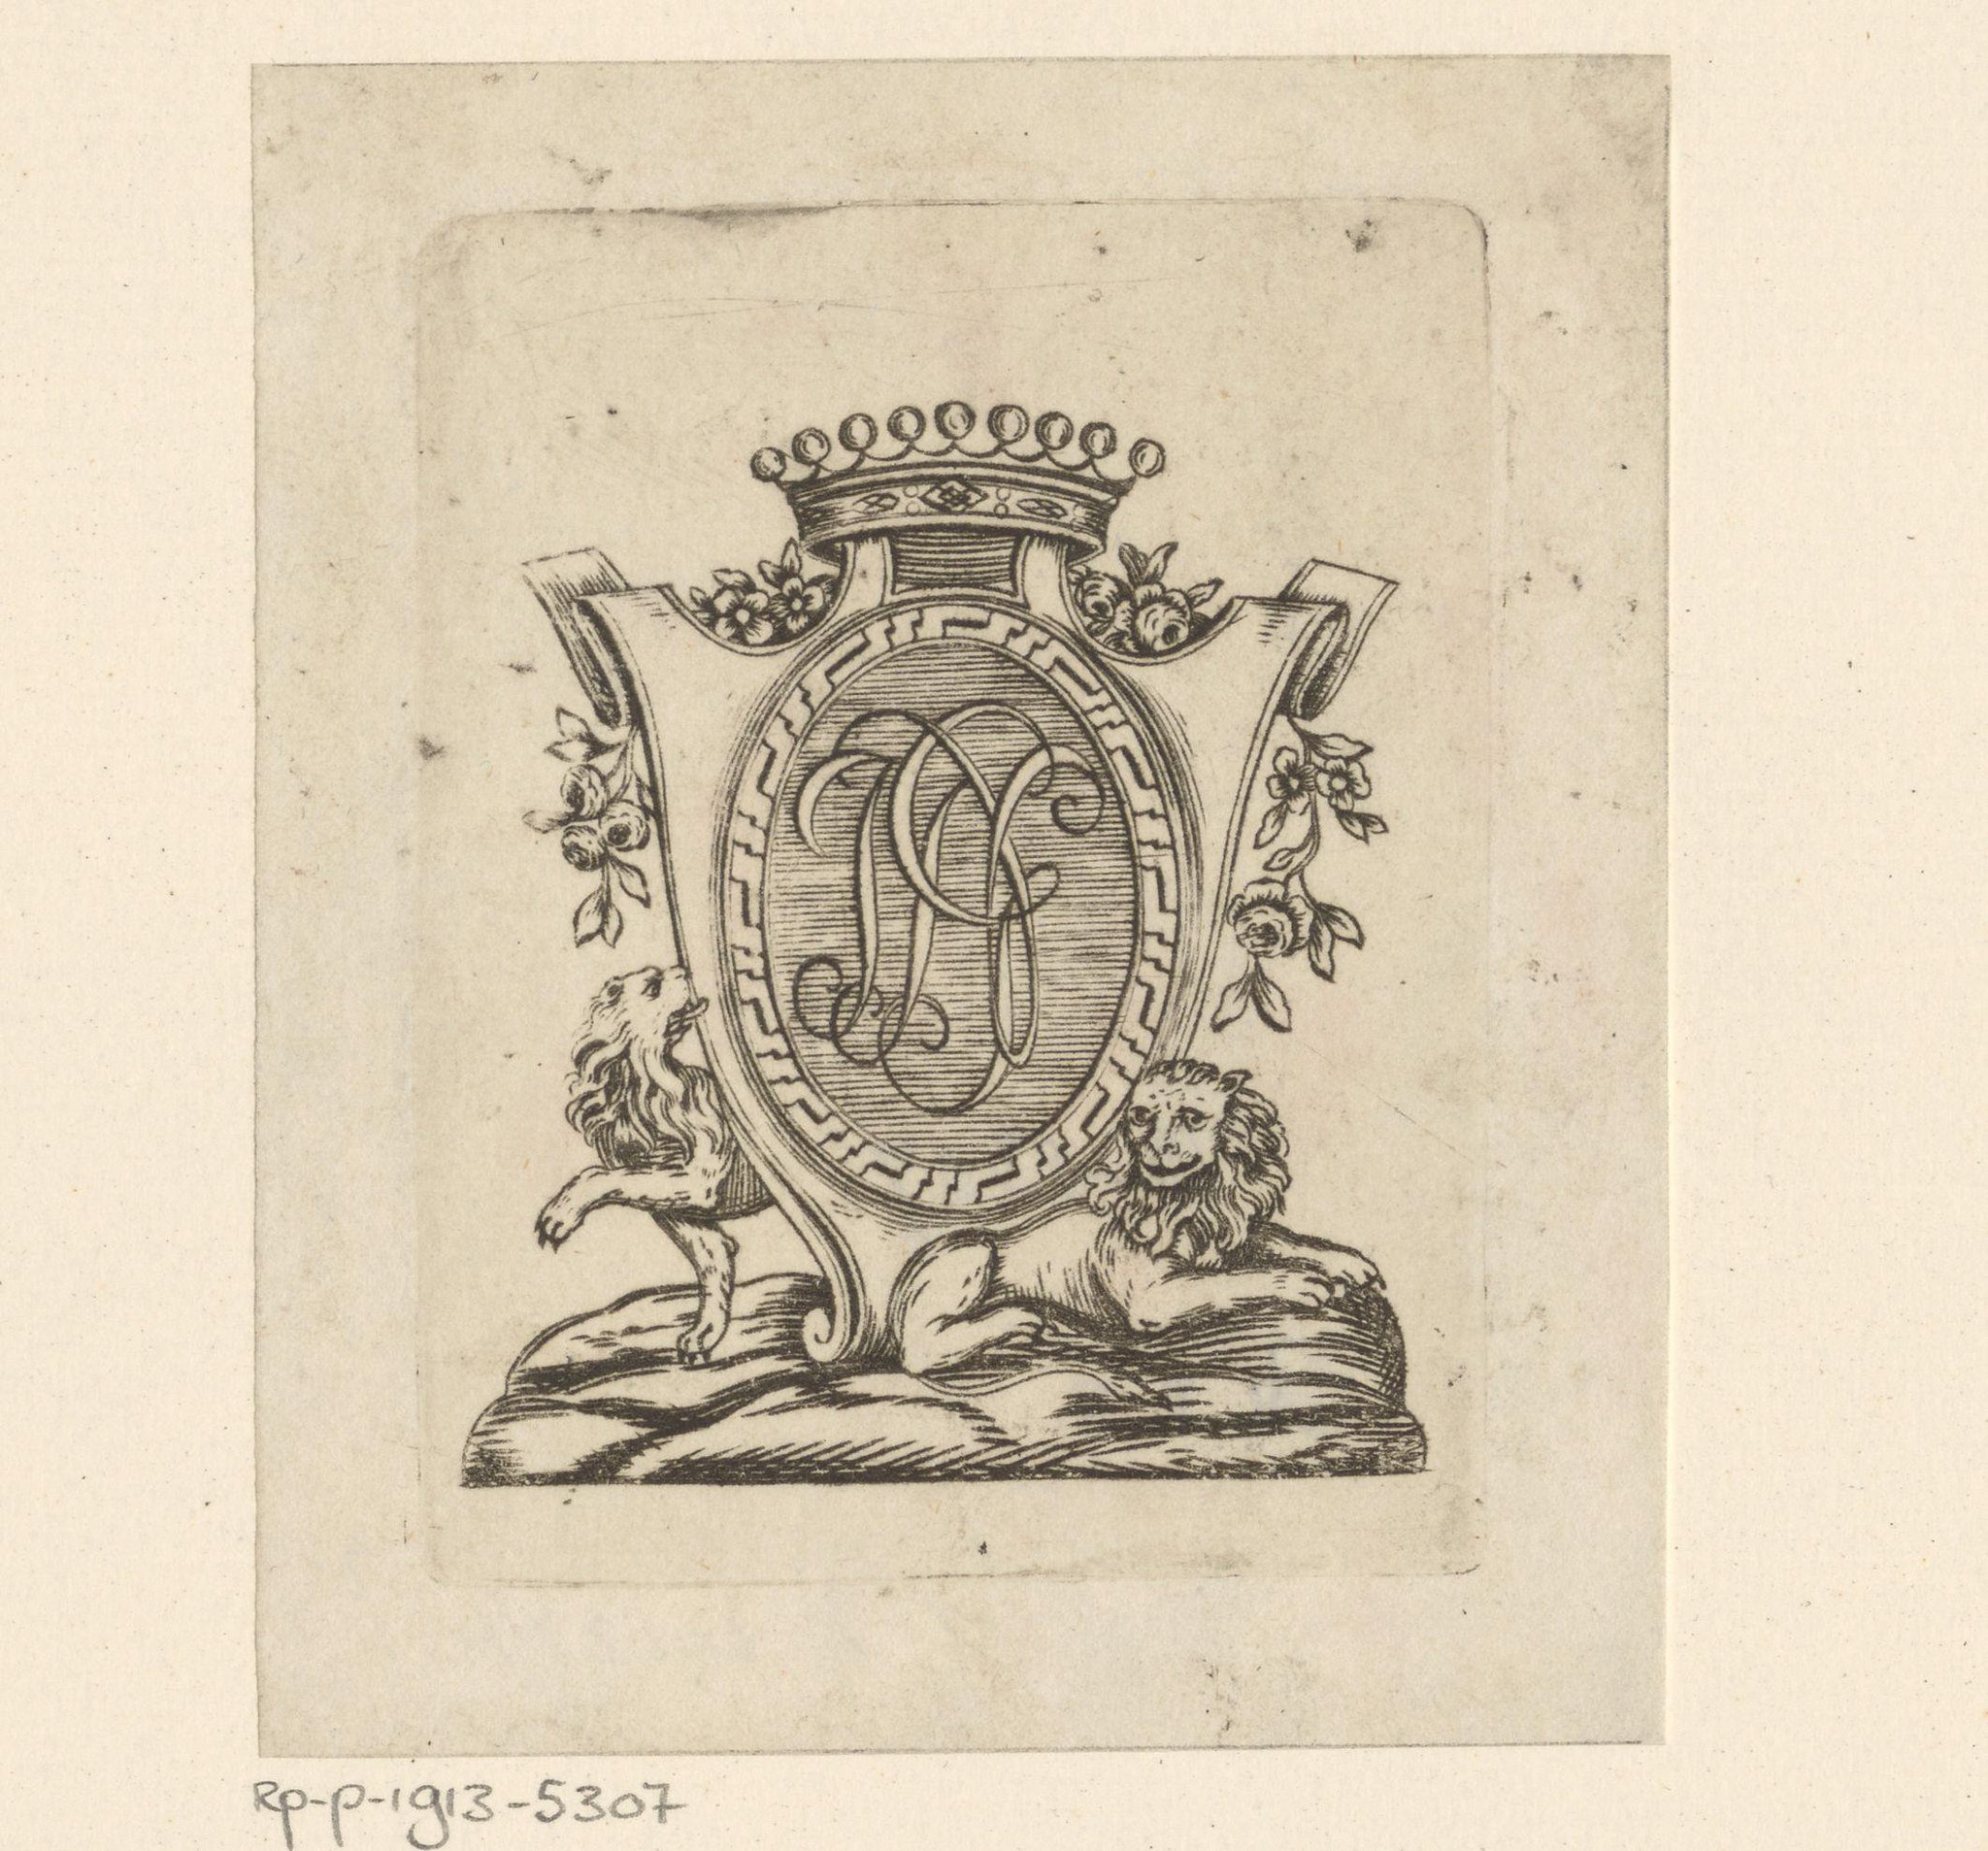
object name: bookplate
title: Ex libris van onbekend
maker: Anonymous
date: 1700-1799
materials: paper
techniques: engraving, etching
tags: initial, beasts of prey, predatory animals: lion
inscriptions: collector's mark: Lugt 2760, collector's mark: Lugt 2233